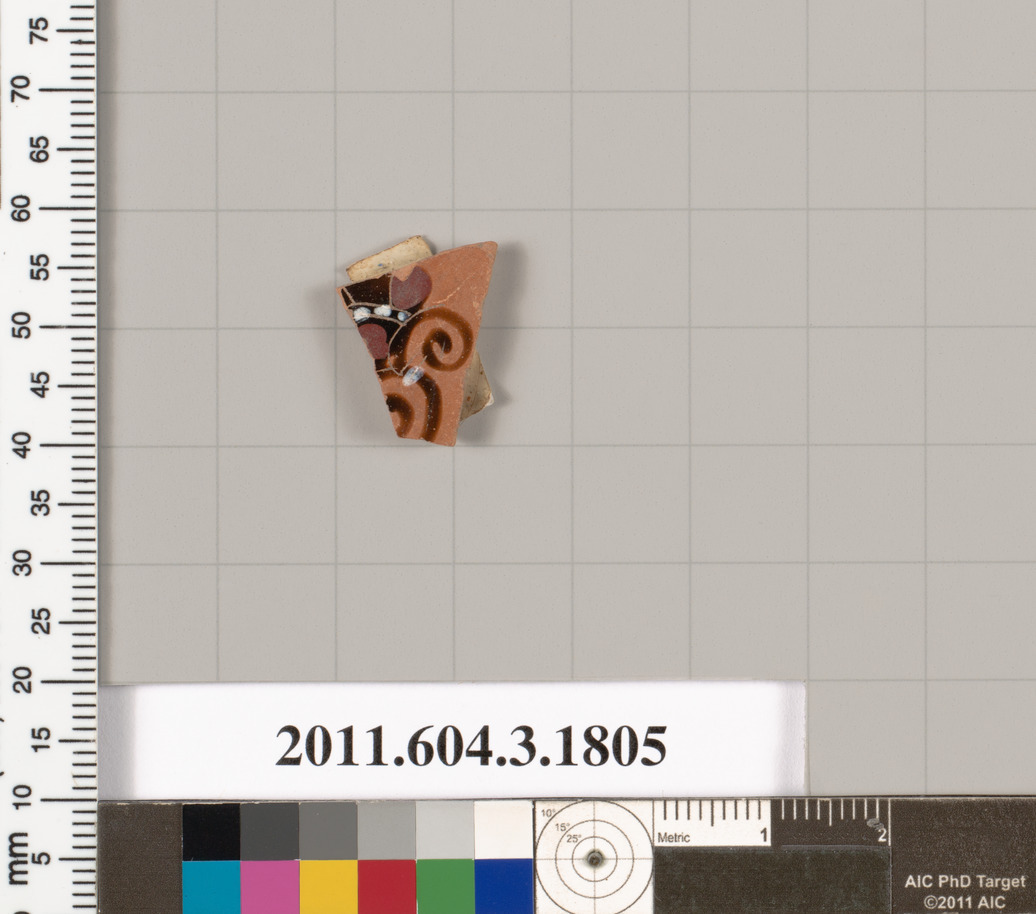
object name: kylix fragment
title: Terracotta fragment of a kylix: Lip cup (drinking cup)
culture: greek, attic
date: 567-535 BCE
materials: terracotta